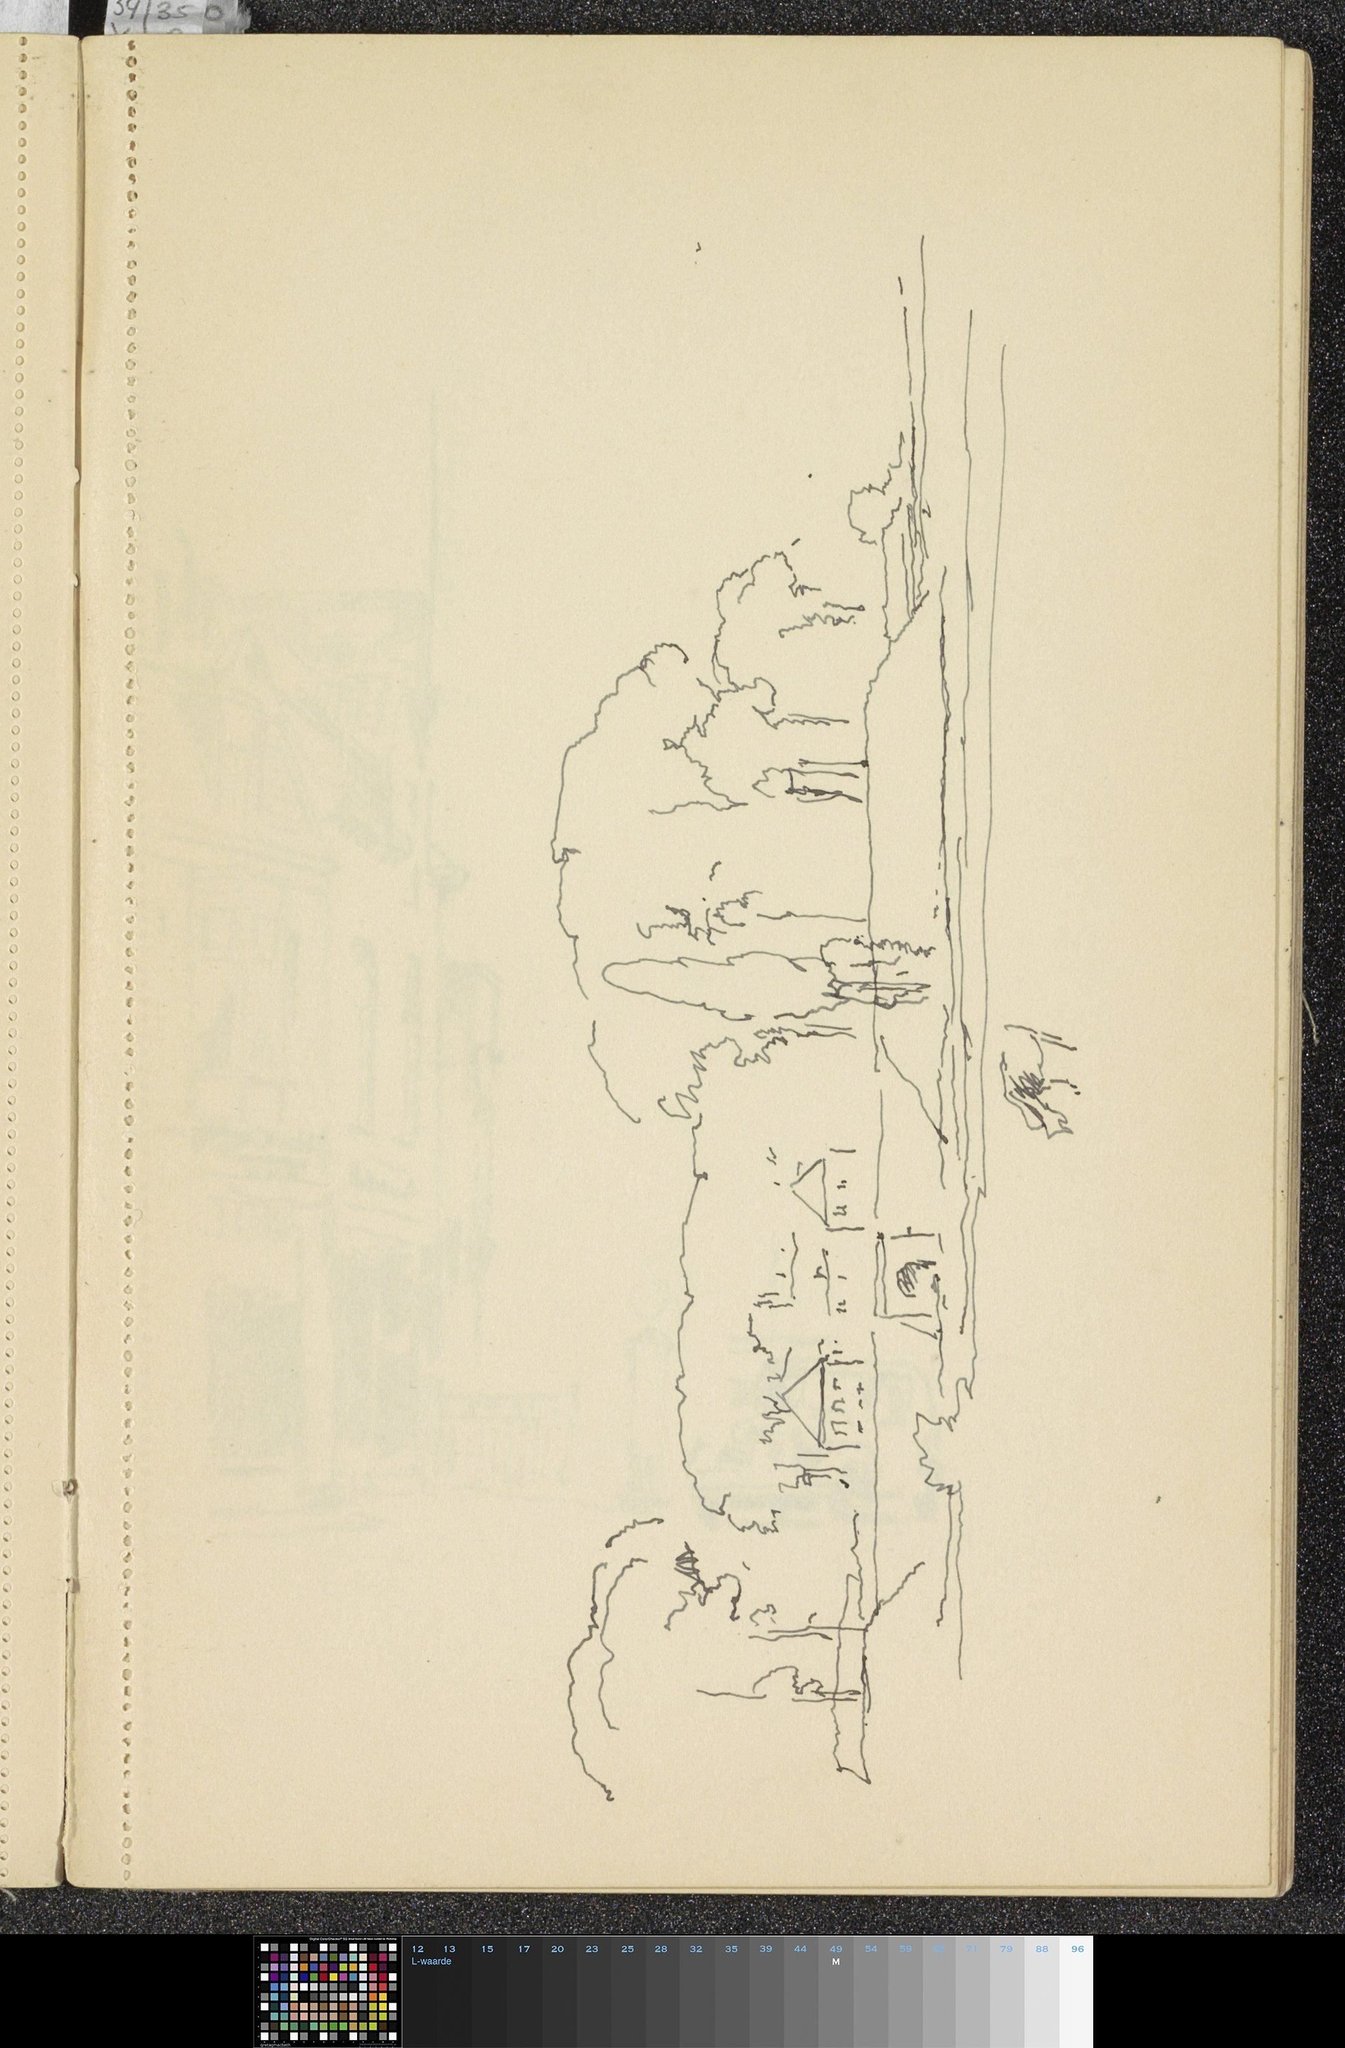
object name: sketchbook leaf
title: Gebouw met twee torens op een heuvel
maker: cornelis vreedenburgh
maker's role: draughtsman, print maker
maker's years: 1880-1946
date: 1890-1946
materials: ink, paper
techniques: pen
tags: city-view, and landscape with man-made constructions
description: Het gebouw staat tussen de bomen. Blad 32 recto uit een schetsboek met 73 bladen.